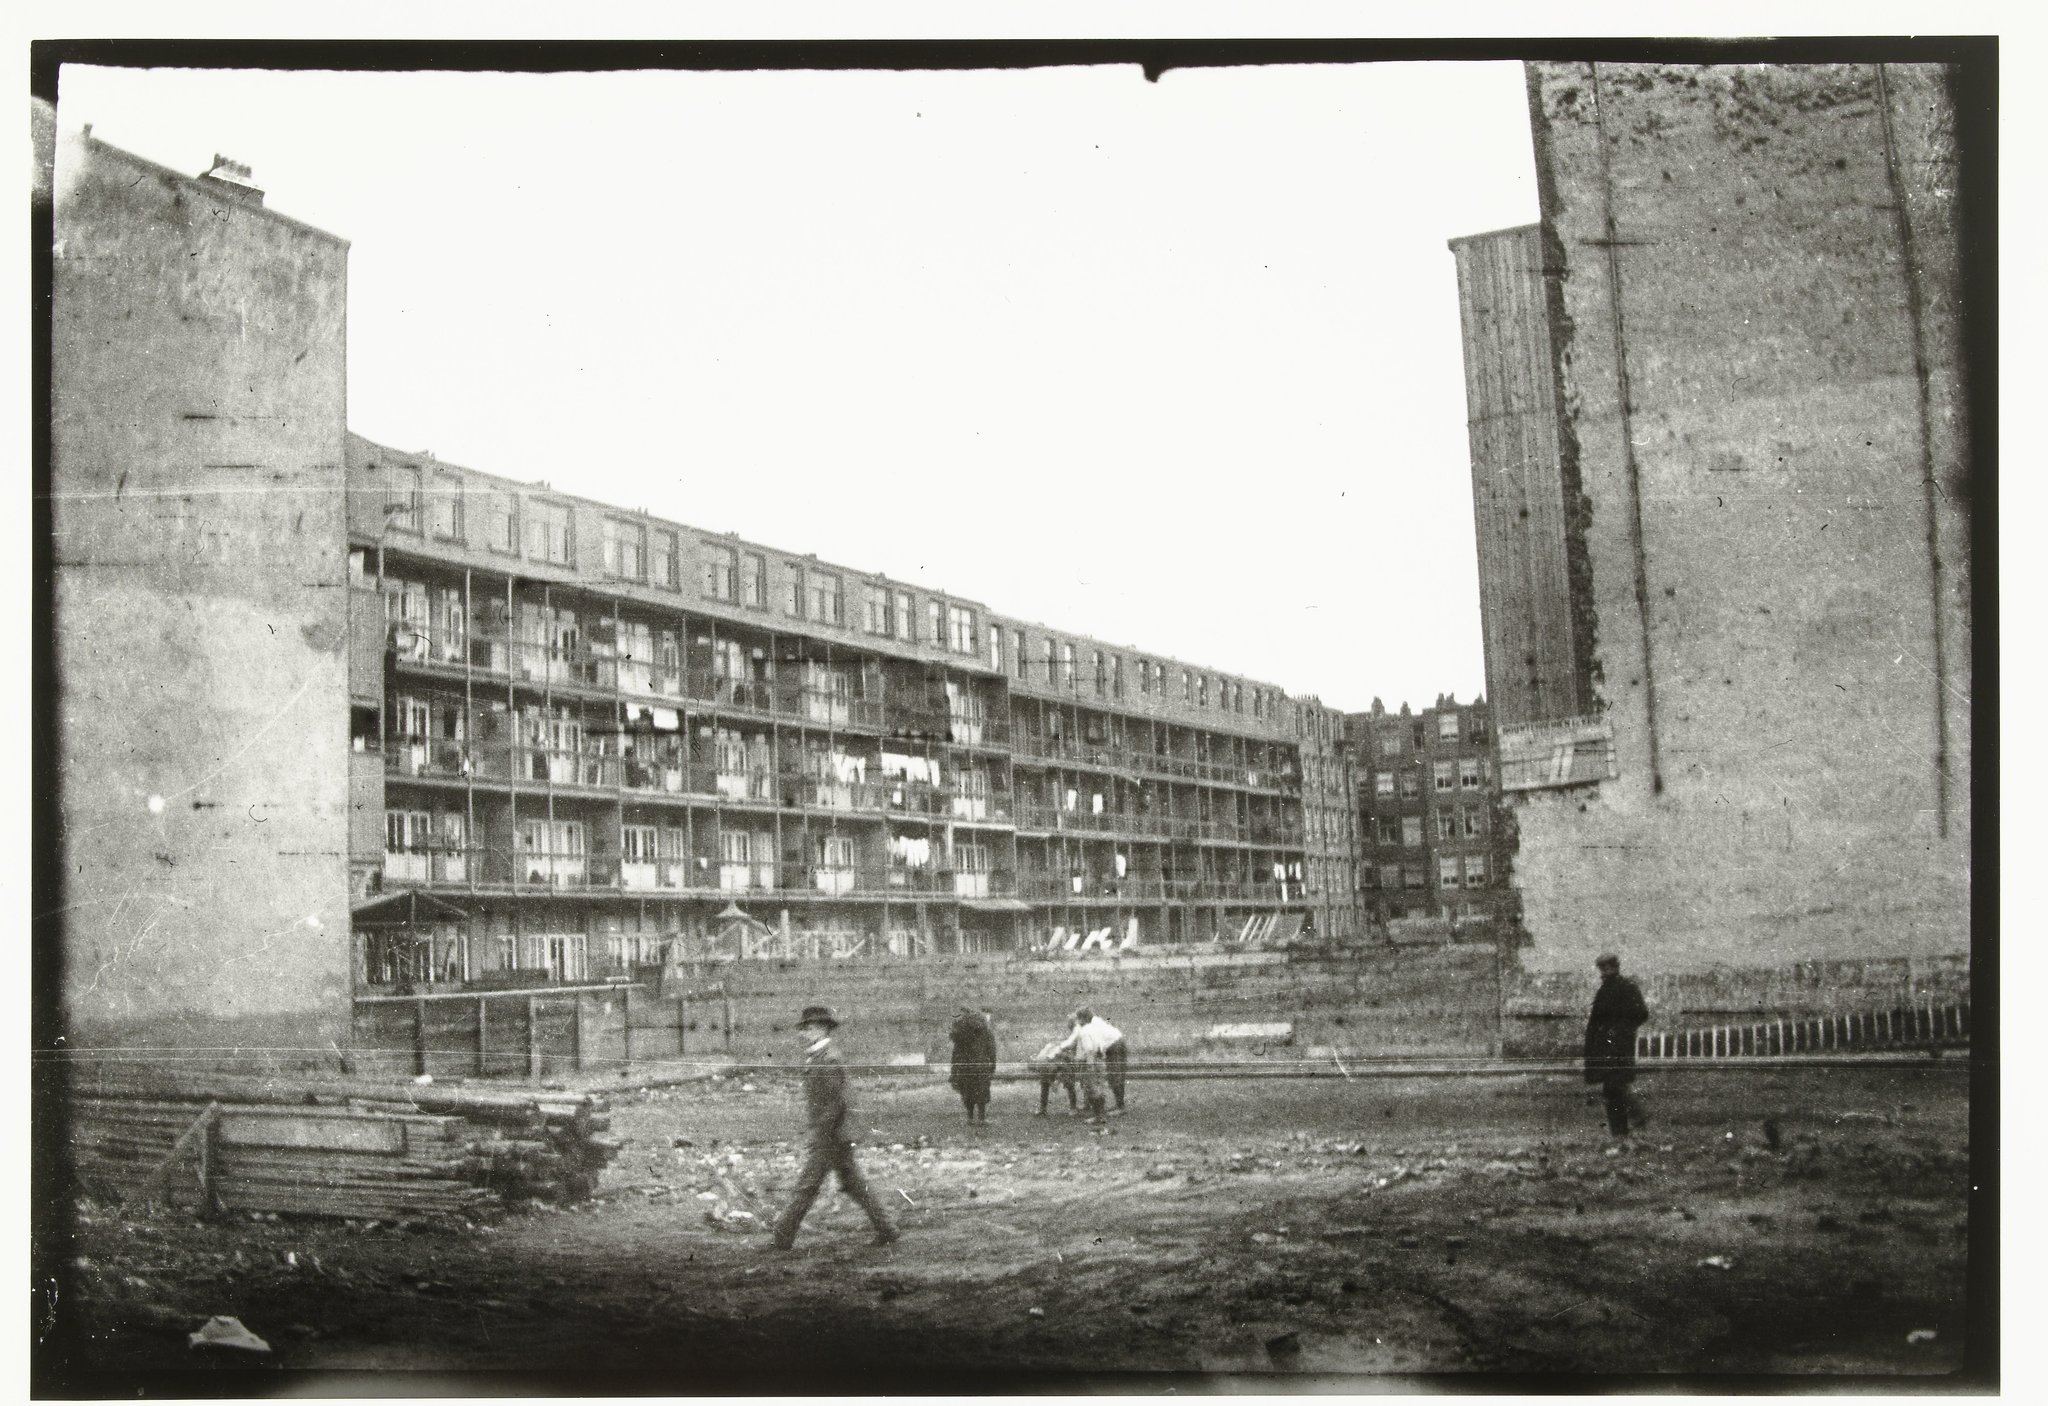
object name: photograph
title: Nieuwbouw aan de Overtoom in Amsterdam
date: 1890-1910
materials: paper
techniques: gelatin silver print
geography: amsterdam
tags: overtoom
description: Moderne afdruk van negatief BR 1141 (collectie RKD).